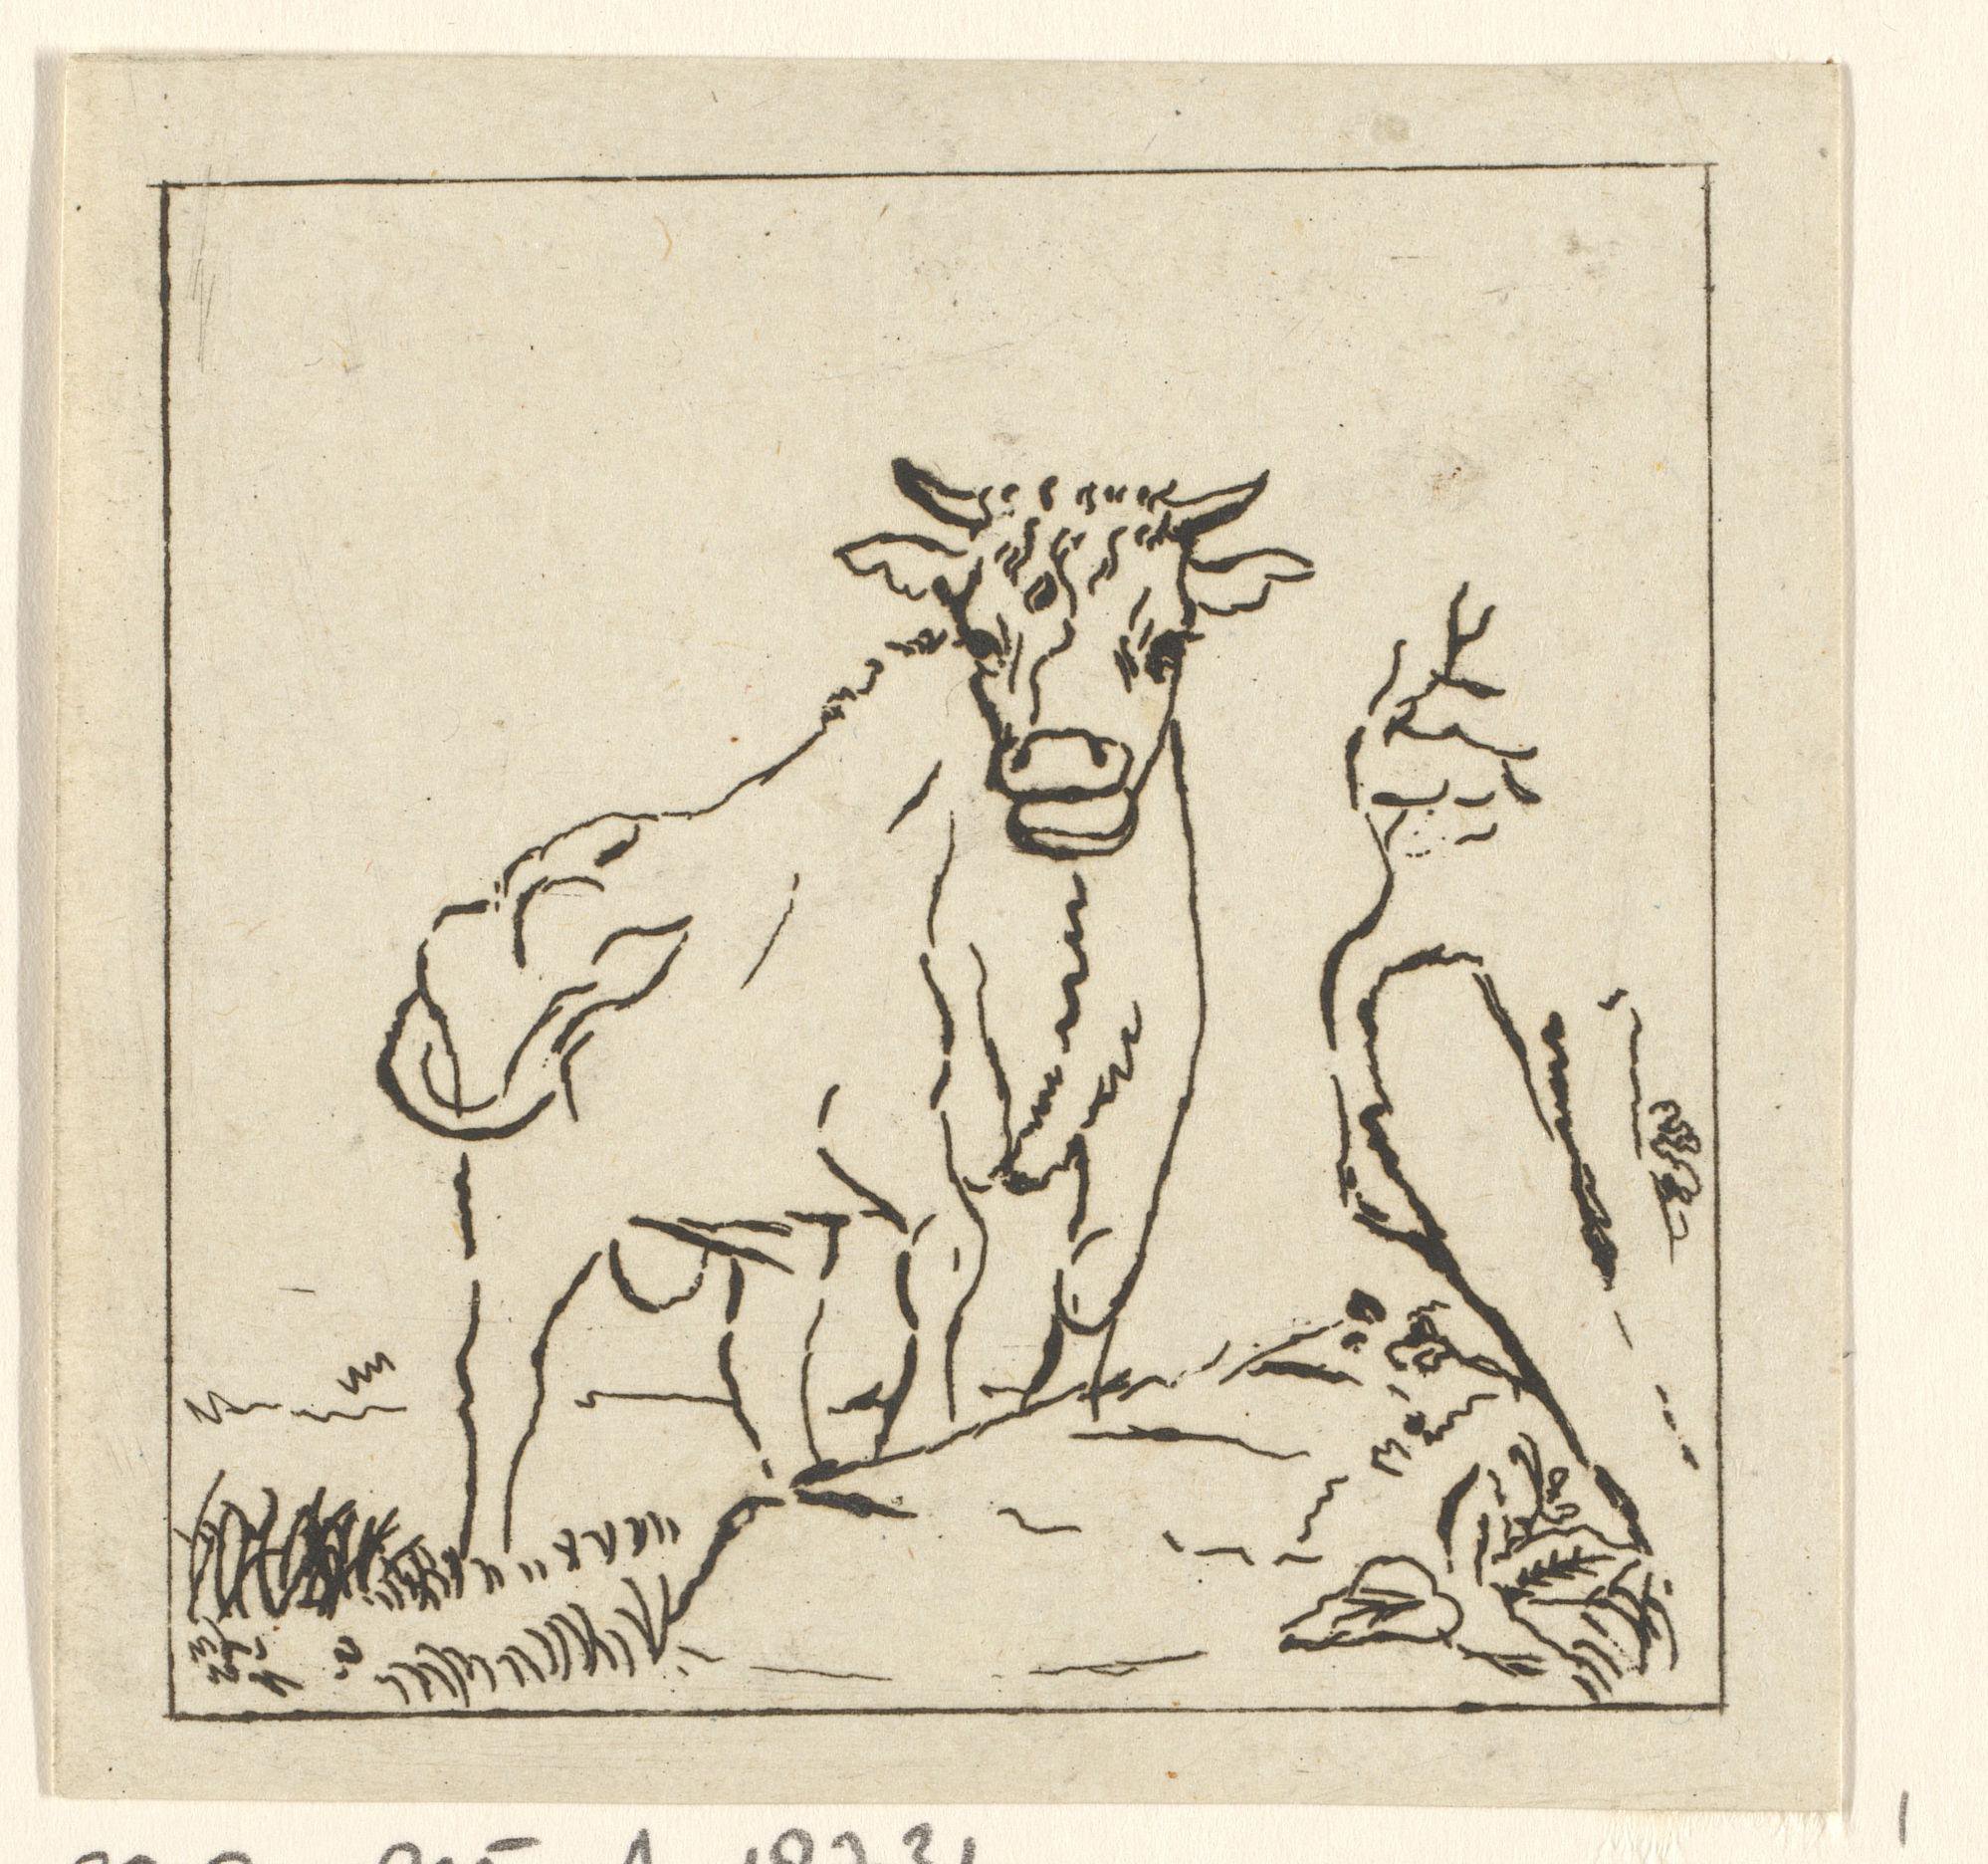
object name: print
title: Koe bij boomstronk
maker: jan van noort (1756-1837)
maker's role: painter, print maker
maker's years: 1756-1837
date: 1766-1837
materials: paper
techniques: etching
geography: leiden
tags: cow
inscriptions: collector's mark: Lugt 2228